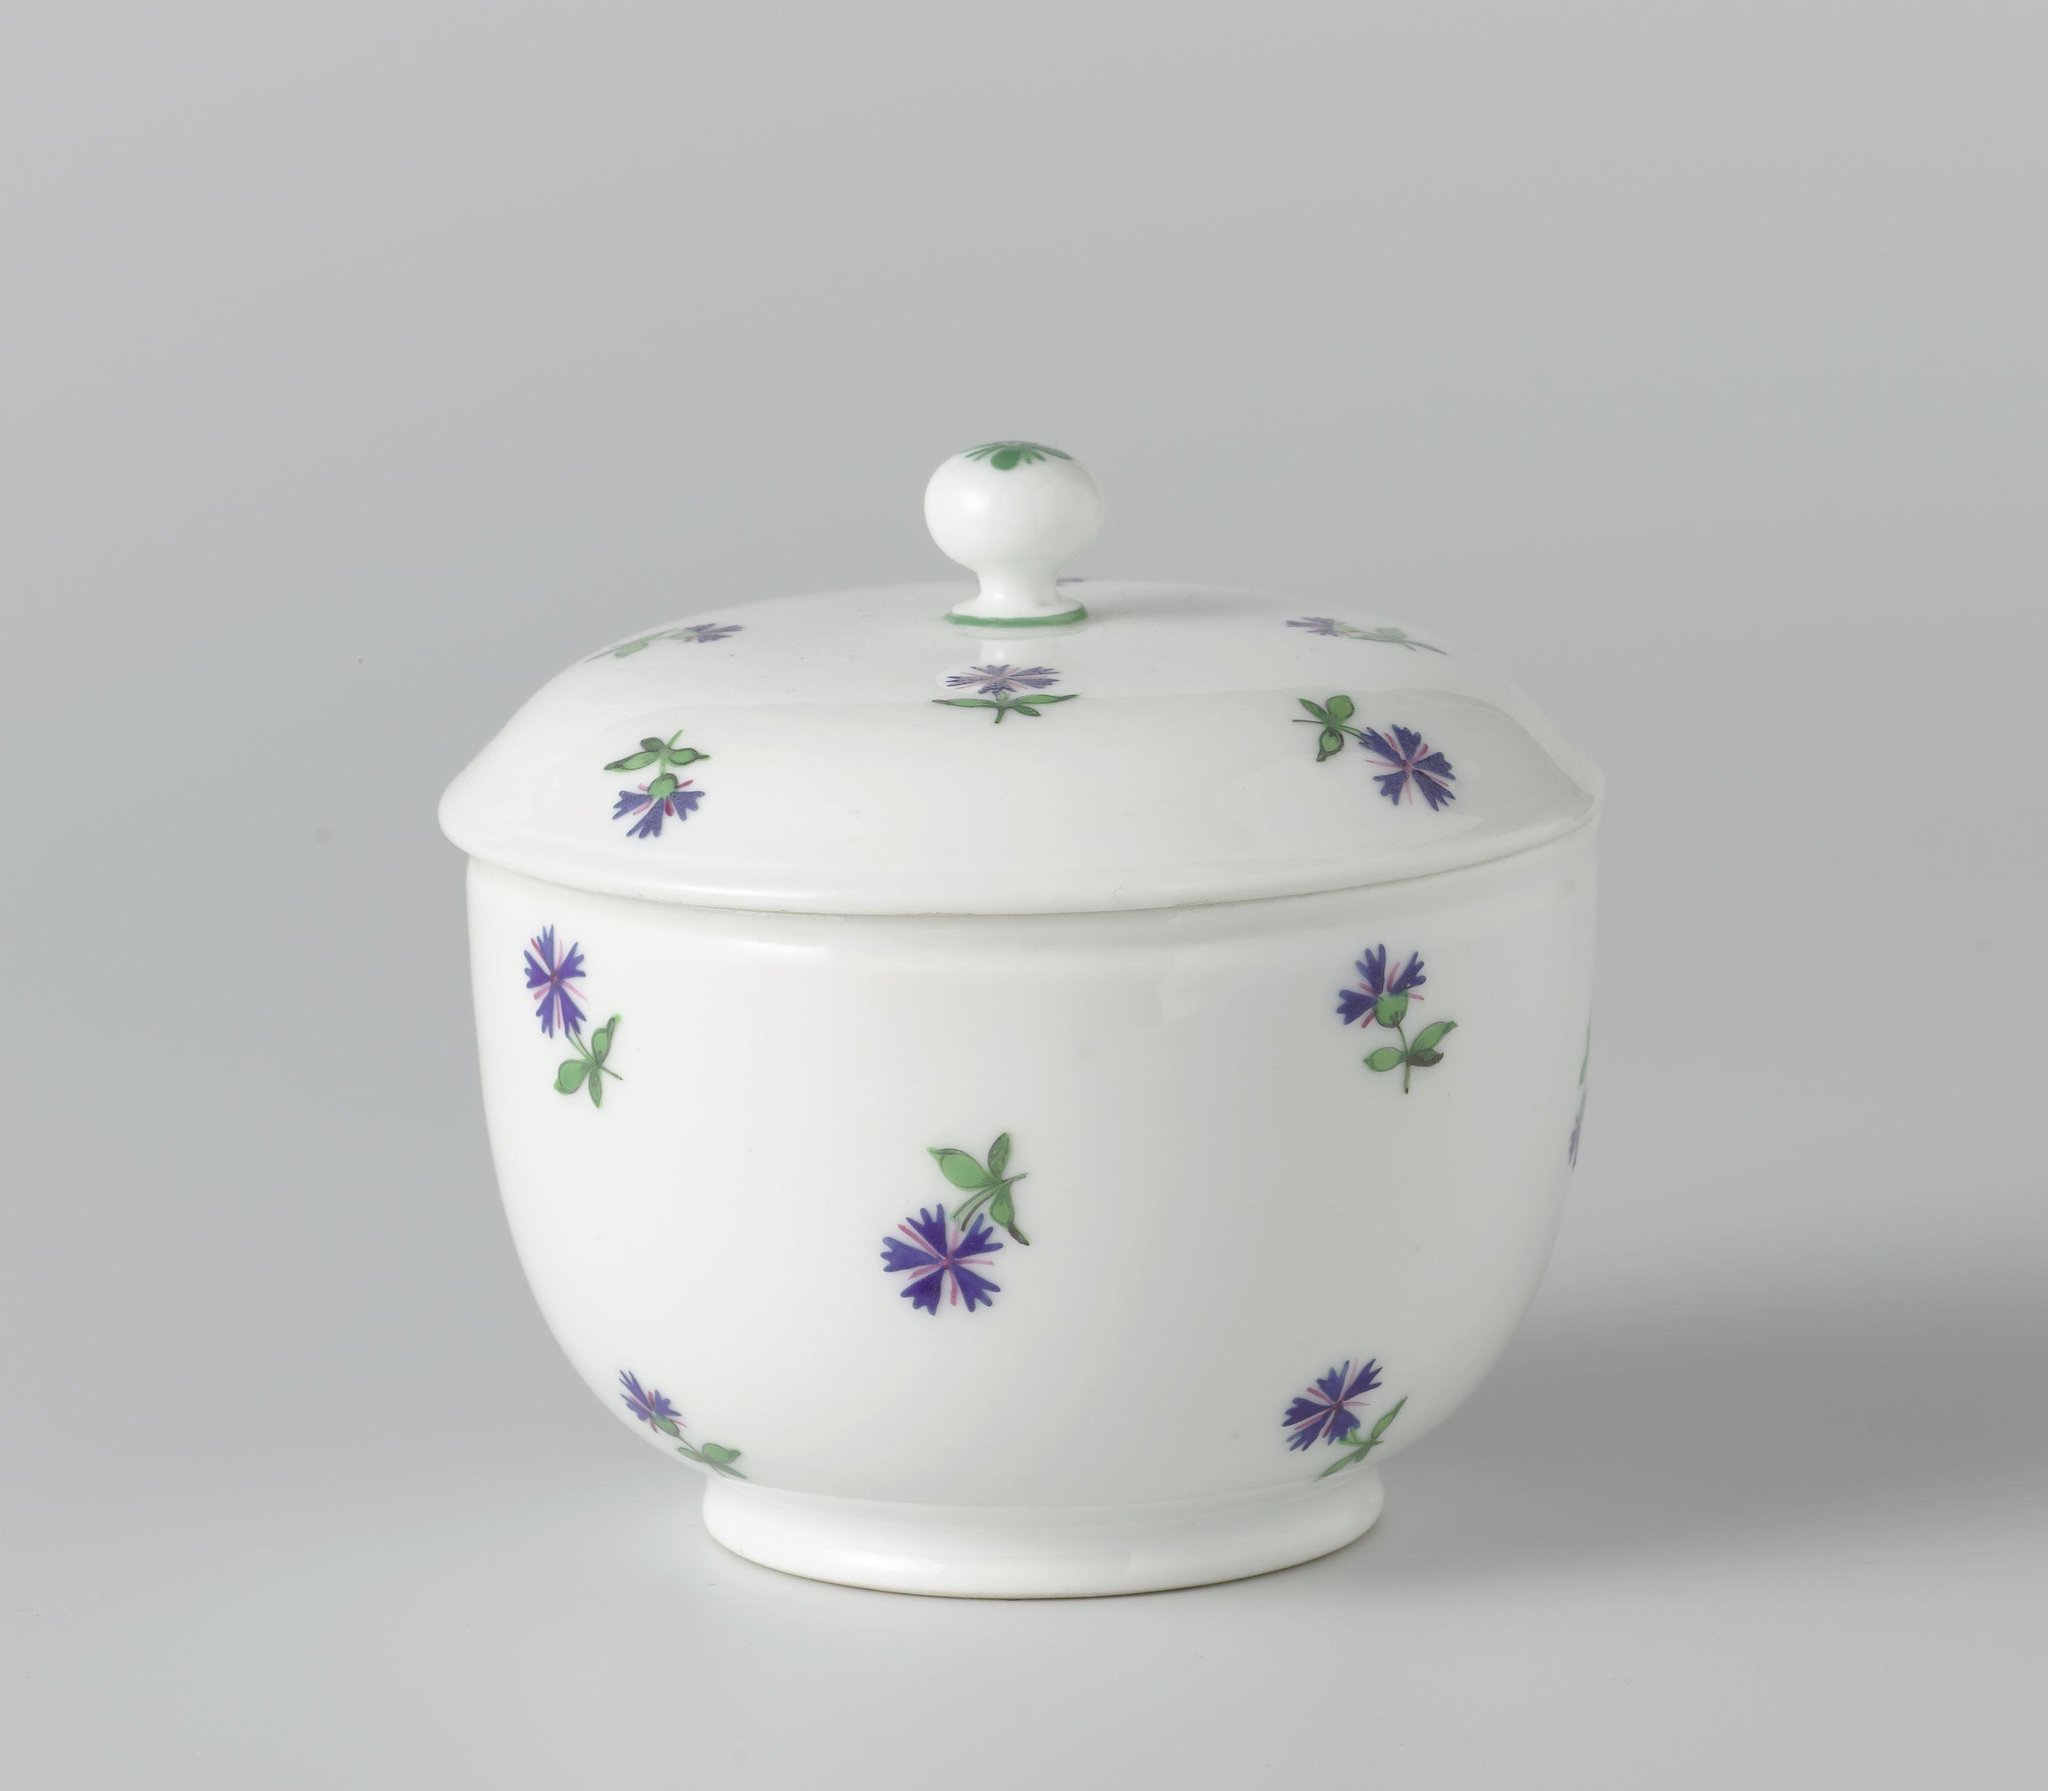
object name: sugar box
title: Suikerpot, beschilderd met korenbloemen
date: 1784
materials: porcelain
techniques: painted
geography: loosdrecht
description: Suikerpot, versierd met korenbloemen. Gemerkt Amstel in blauw onder het glazuur. Suikerpot gebarsten.